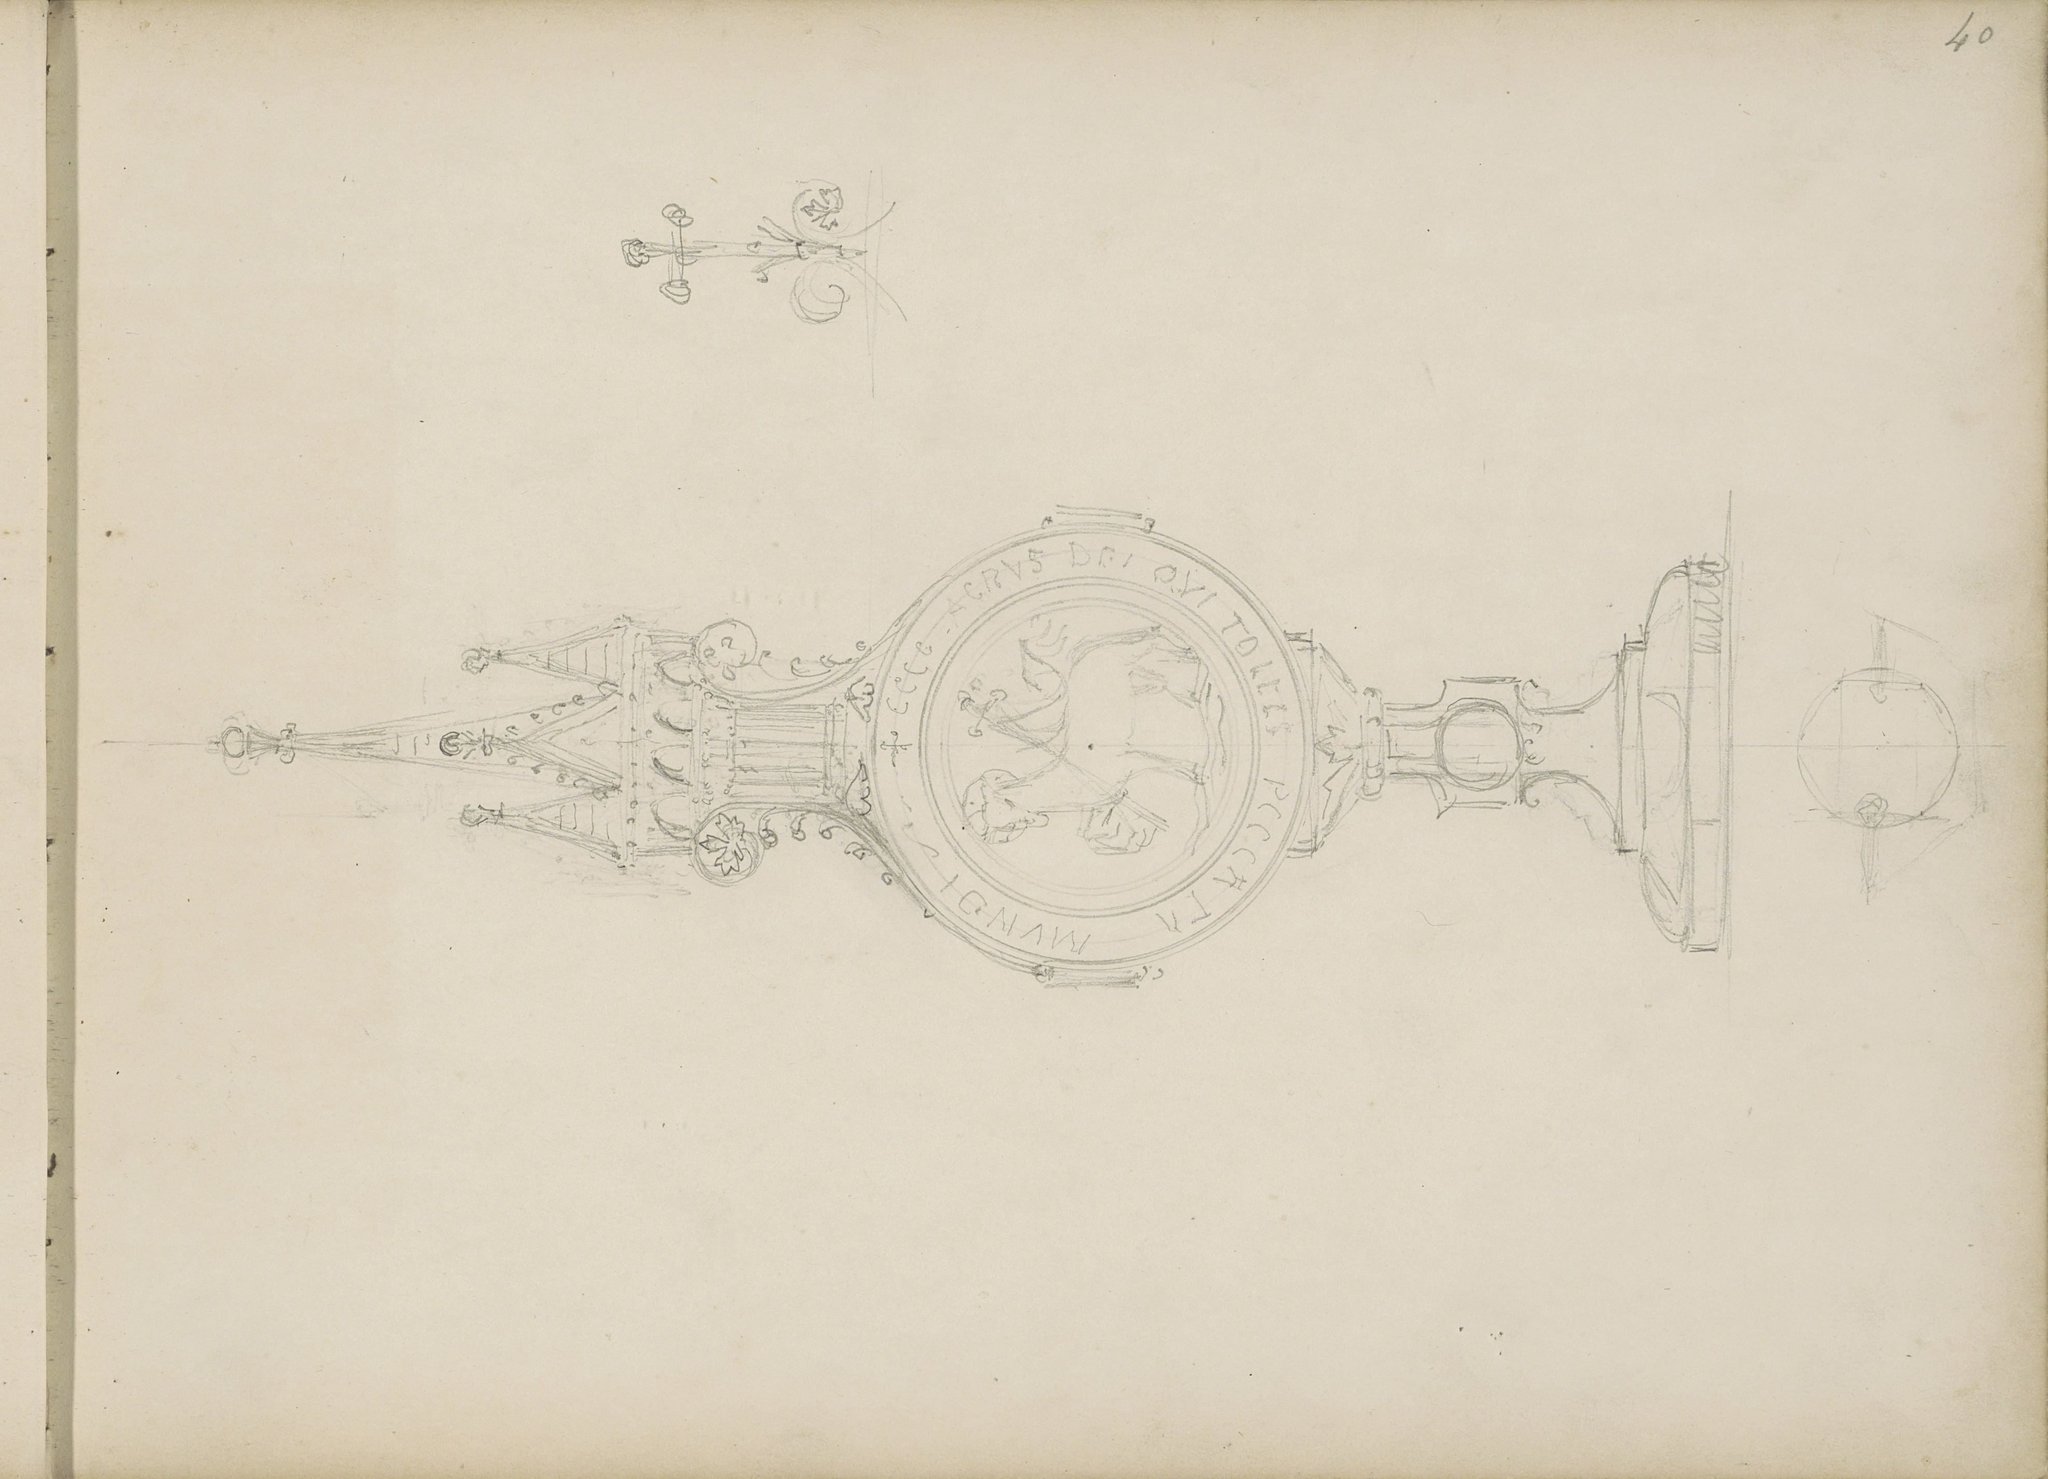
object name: sketchbook leaf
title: Reliekschrijn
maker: pierre joseph hubert cuypers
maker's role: draughtsman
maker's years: 1827-1921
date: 1857-1859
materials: paper, pencil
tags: lamb bearing cross or banner, 'agnus dei' ~ symbol of christ, relics (and reliquaries)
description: Op het schrijn staat het Lam Gods met nimbus en kruis (Agnus Dei) afgebeeld, als symbool voor de offerdood van Christus. Blad 40 recto uit een schetsboek met 77 bladen.